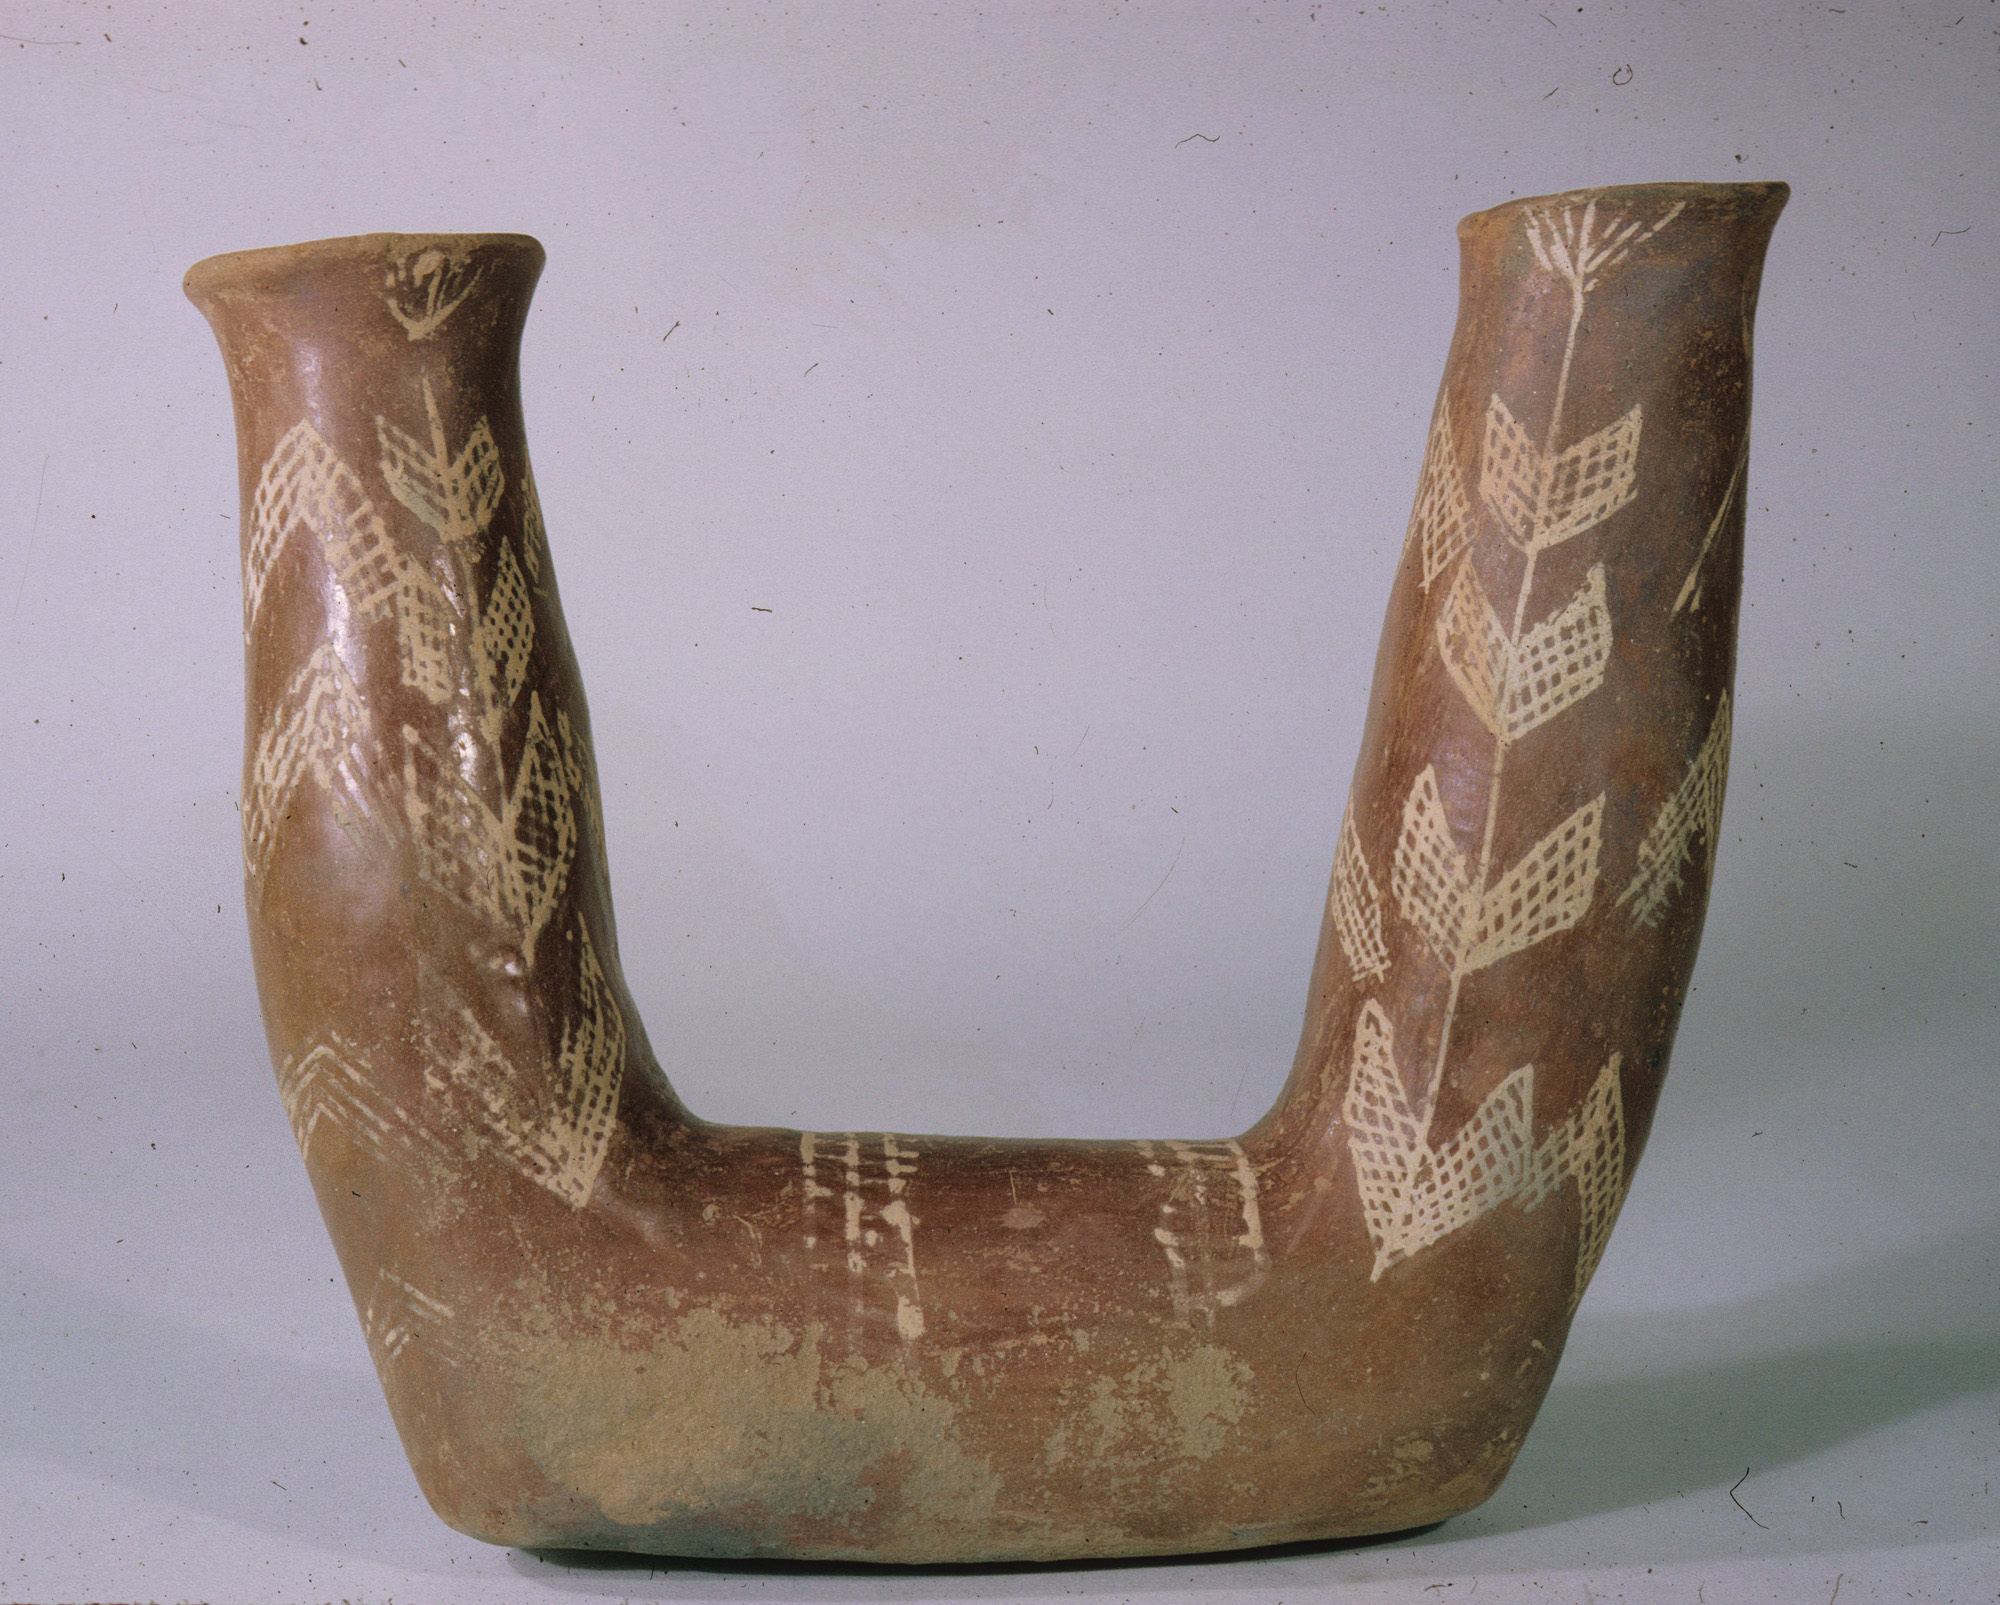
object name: jar, white cross lined ware, double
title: Double jar of white cross-lined ware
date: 3700-3500 BCE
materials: paint, pottery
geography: egypt